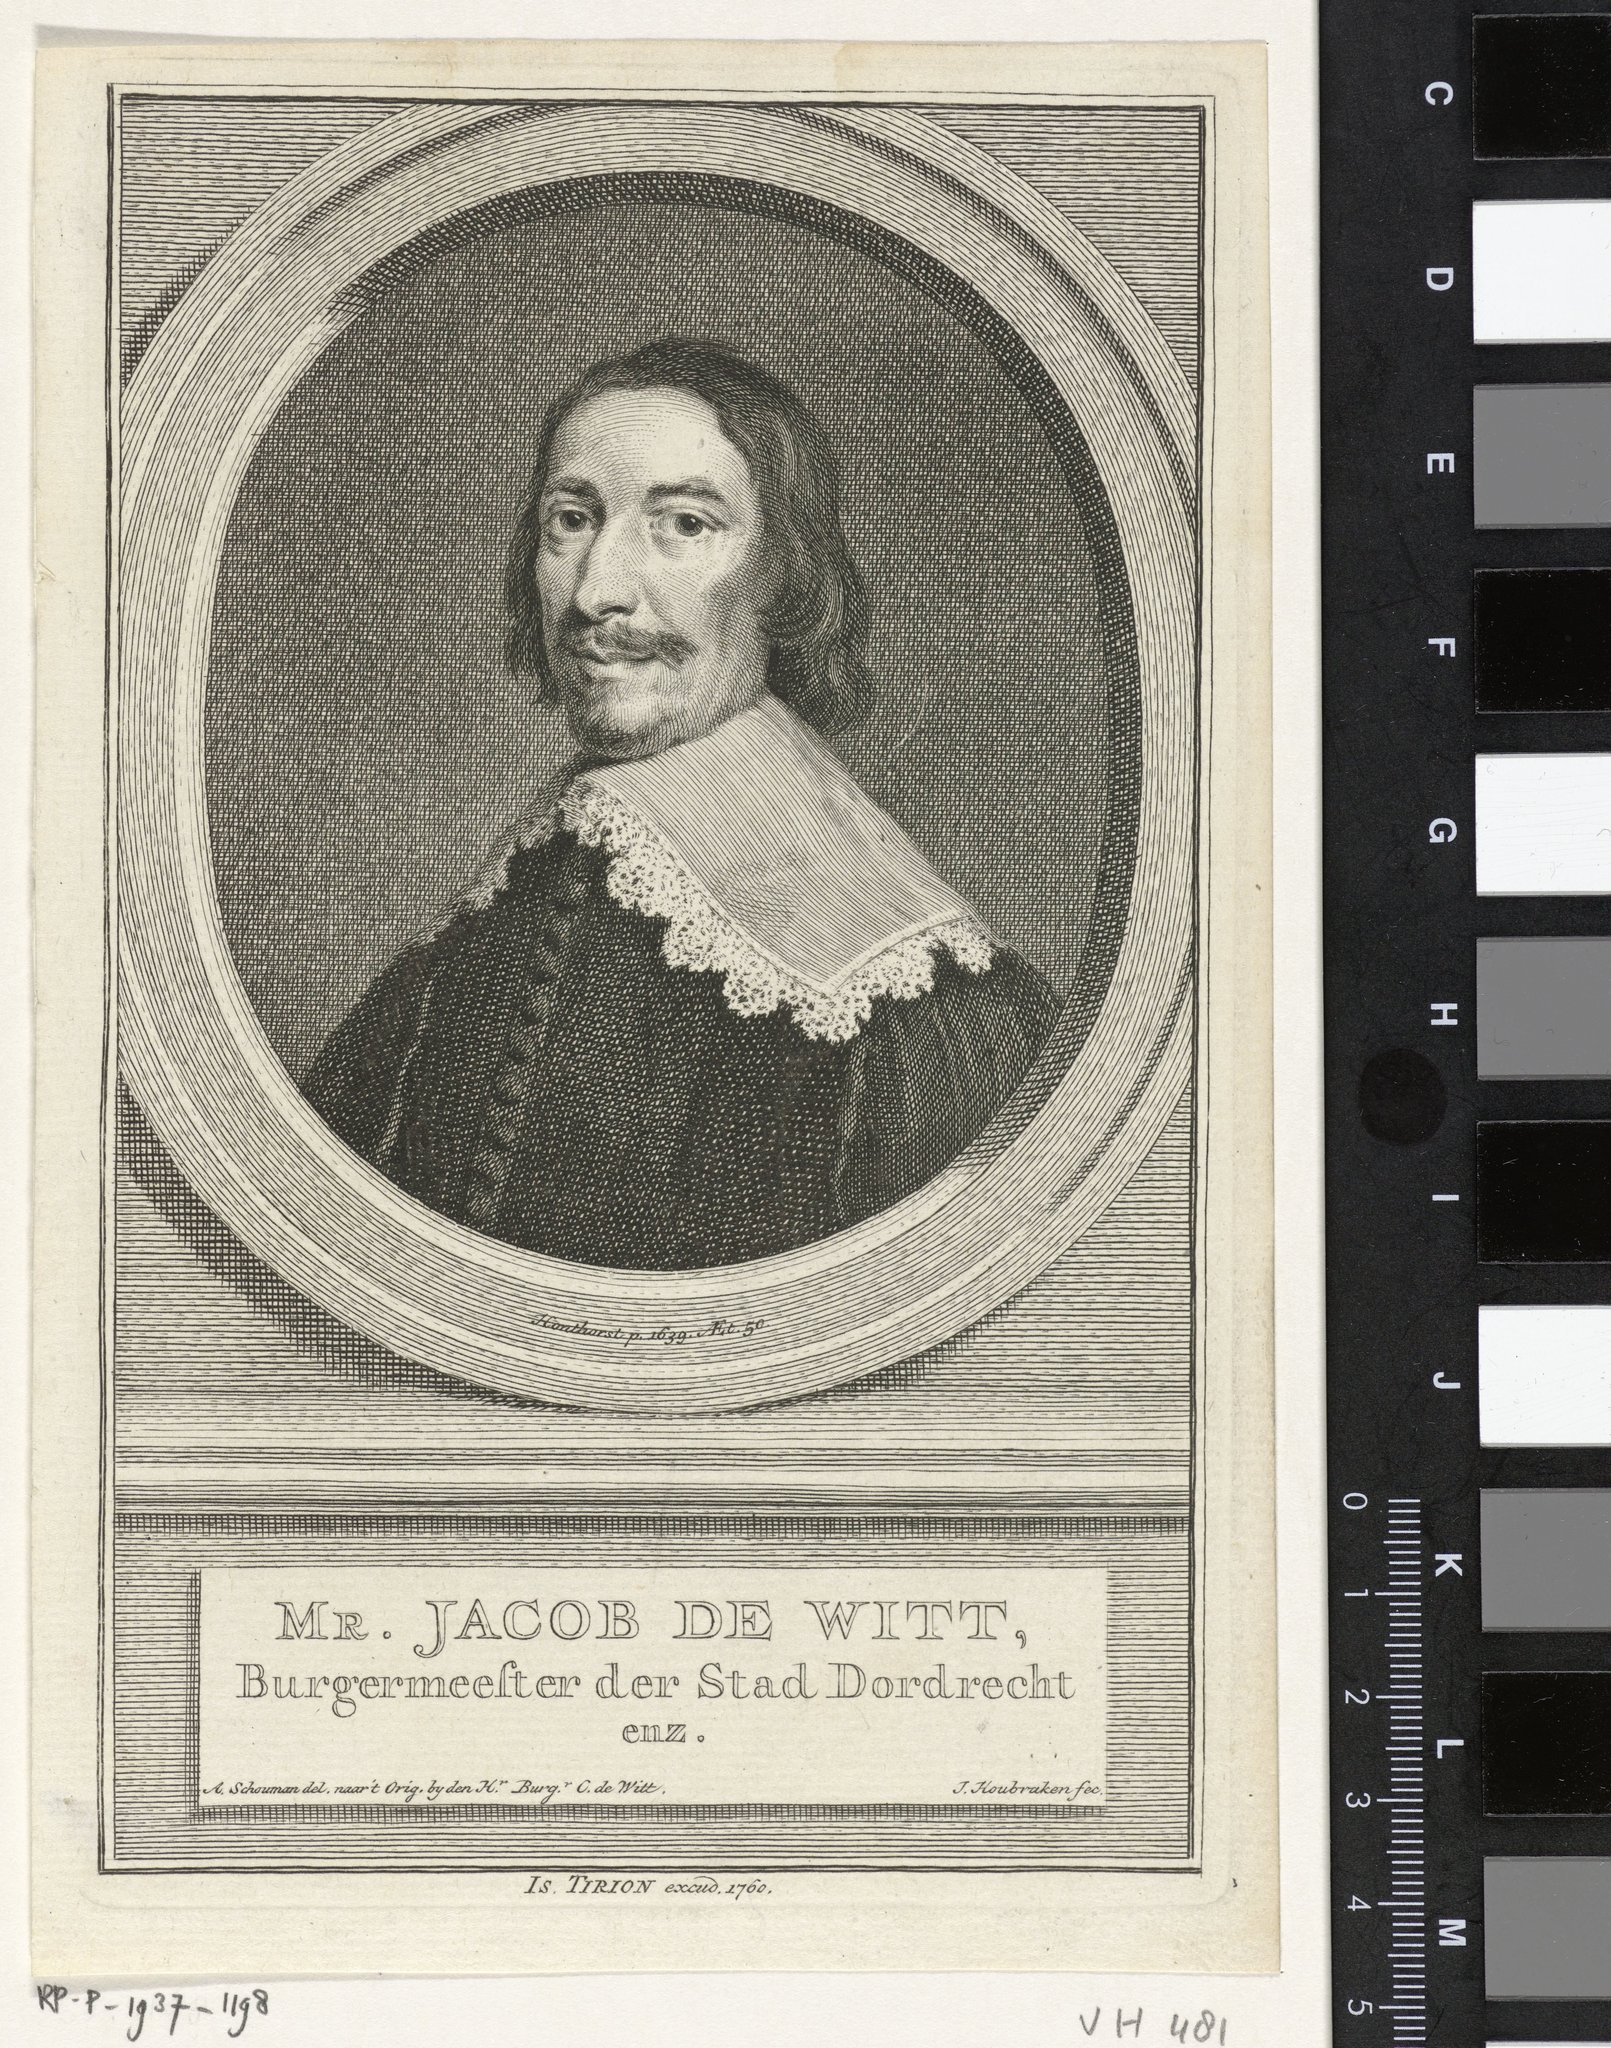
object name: print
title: Portret van Jacob de Witt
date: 1760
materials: paper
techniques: engraving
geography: amsterdam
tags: jacob de witt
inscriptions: collector's mark: Lugt 2228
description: Prent ook gebruikt in: Portraiten van vermaarde persoonadien, dienende tot een aanhangsel op de Vaderlandsche historie. Amsterdam, Isaak Tirion, 1761.